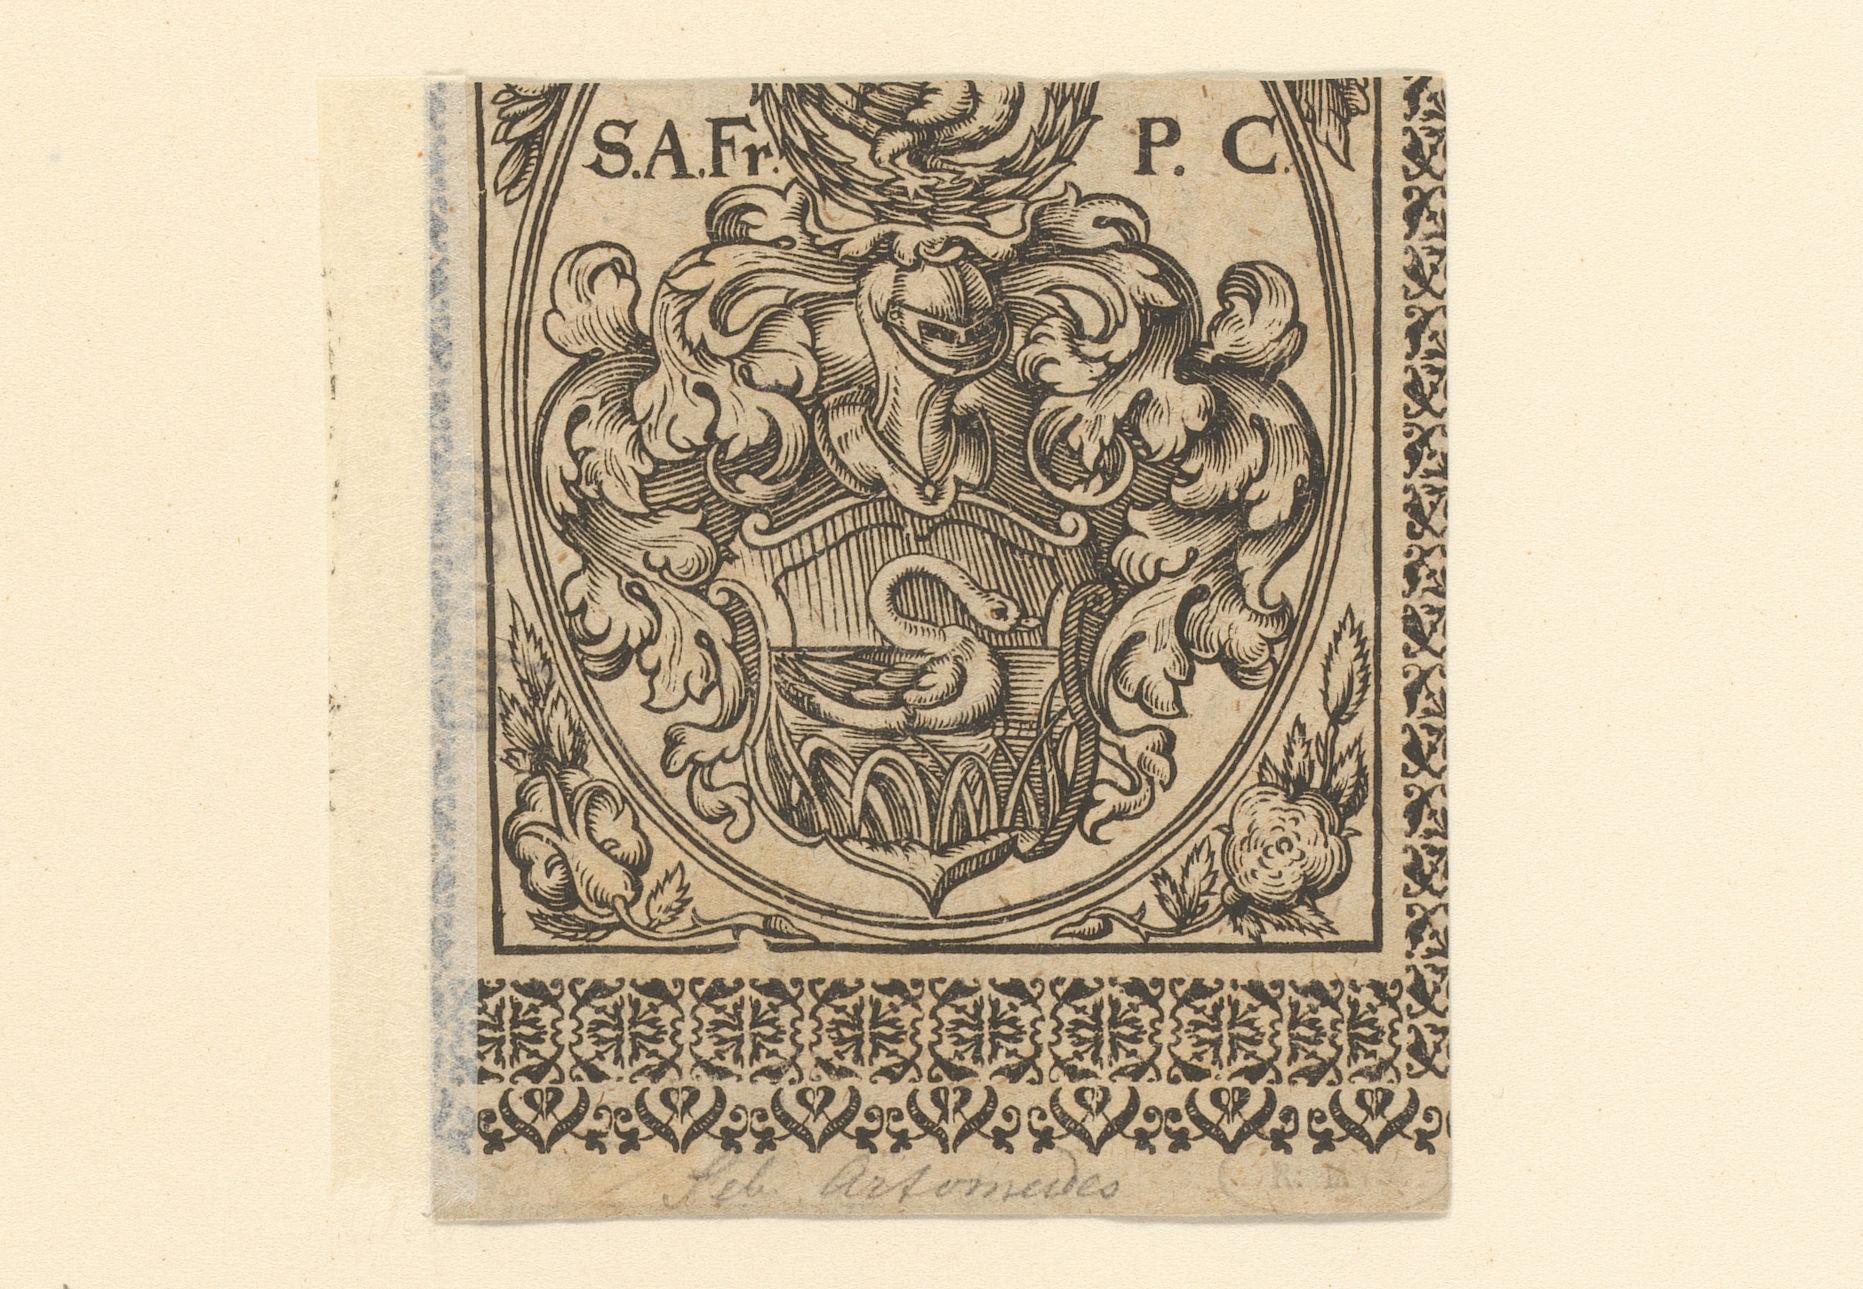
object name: print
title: Onbekend familiewapen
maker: Anonymous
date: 1600-1625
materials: paper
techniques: woodcut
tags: armorial bearing, heraldry